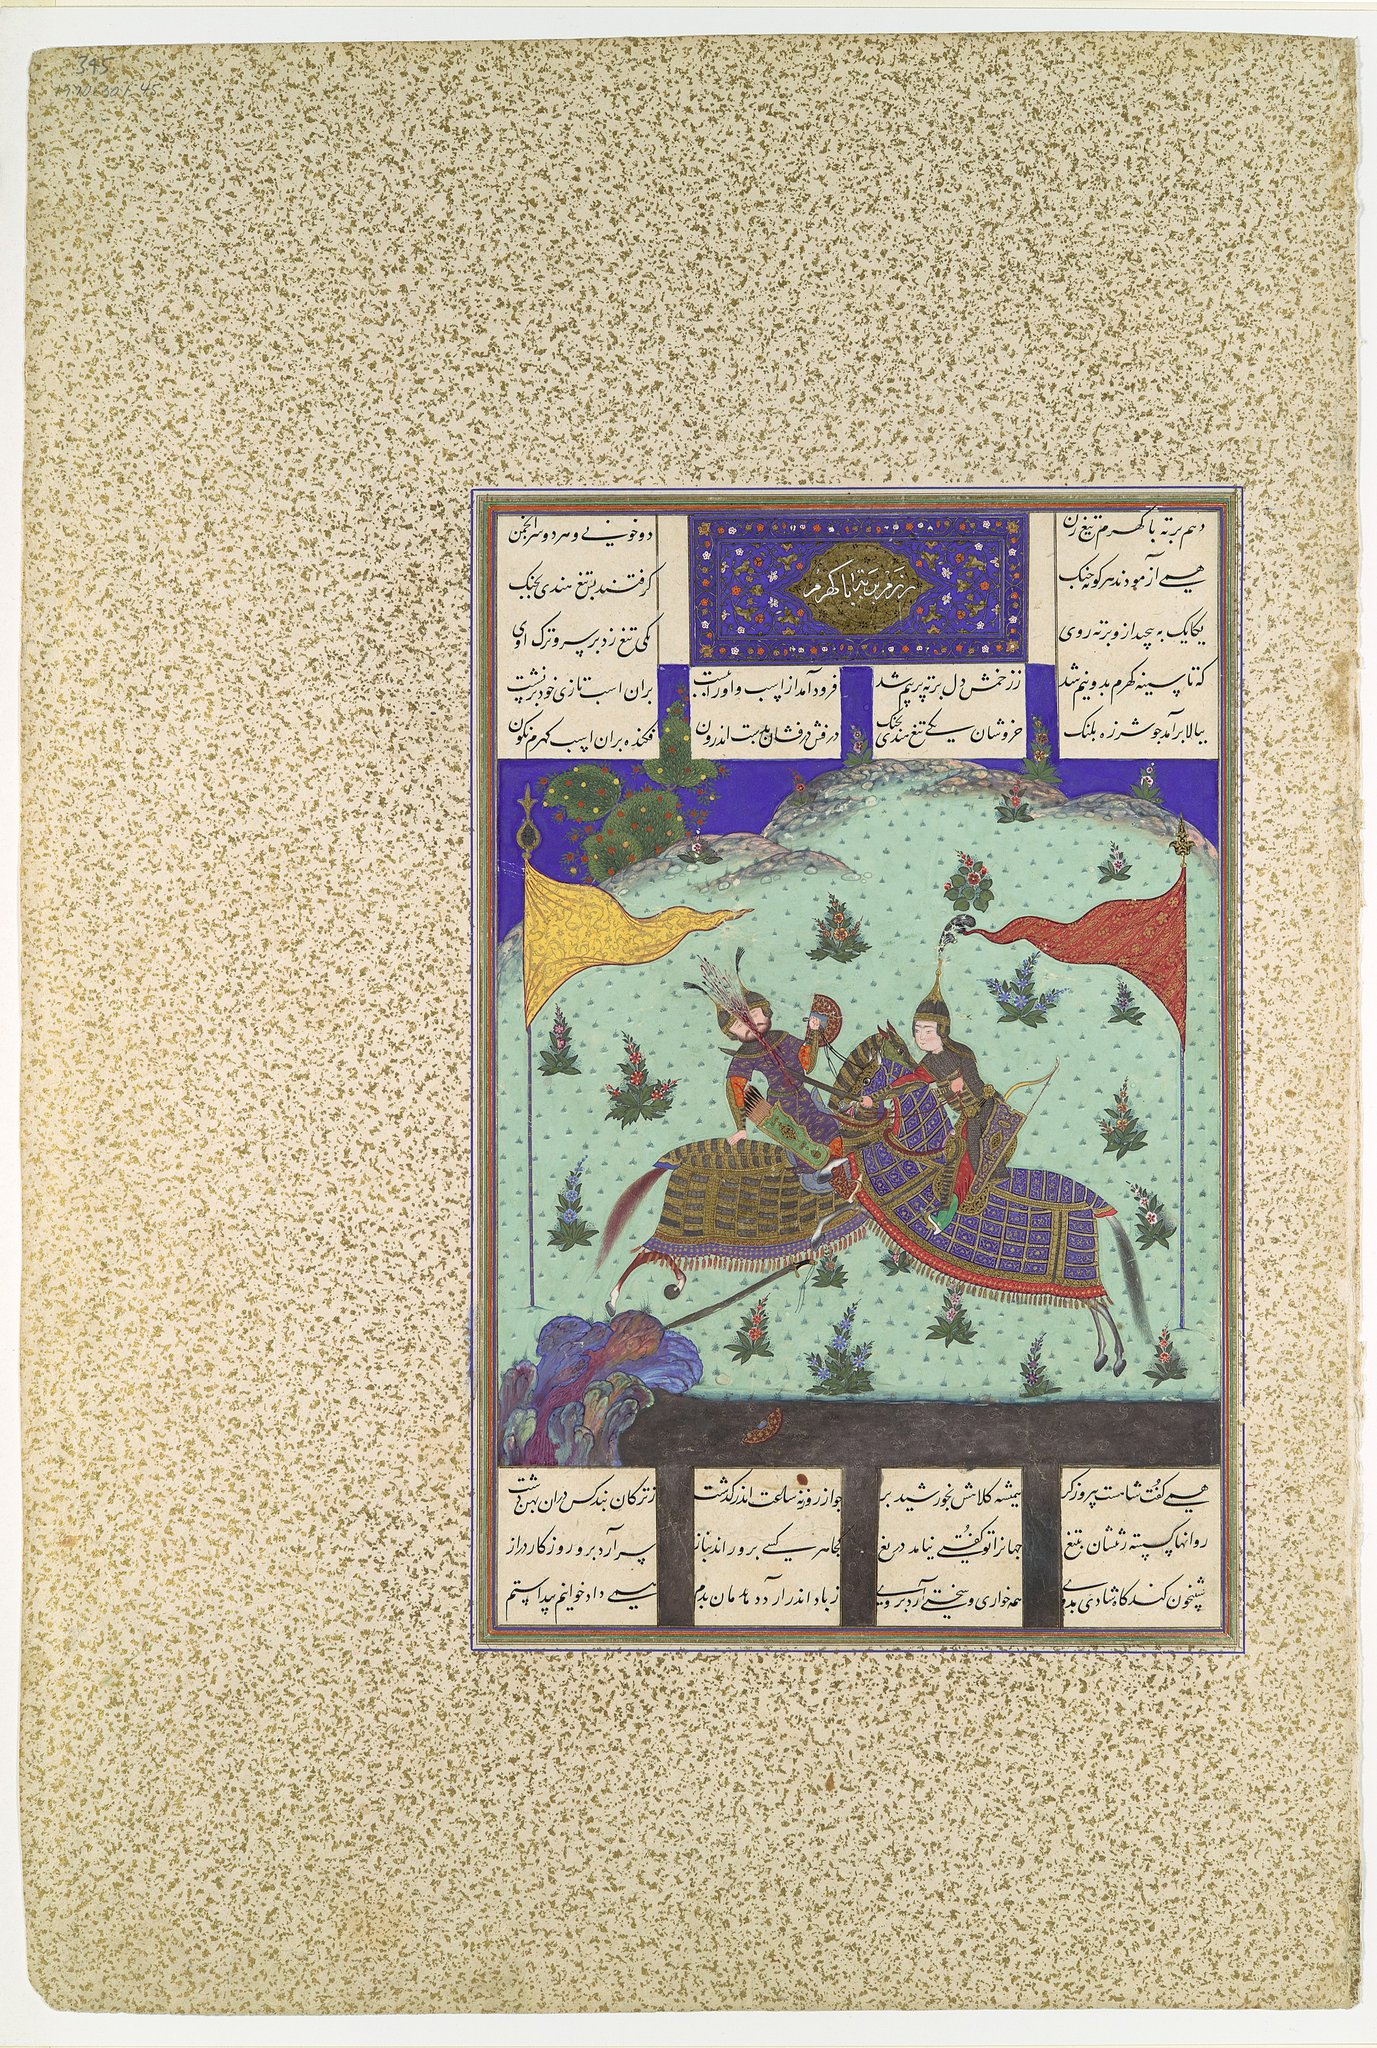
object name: folio from an illustrated manuscript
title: "The Tenth Joust of the Rooks: Barta versus Kuhram," Folio 345r from the Shahnama (Book of Kings) of Shah Tahmasp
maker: abu'l qasim firdausi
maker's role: author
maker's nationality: iranian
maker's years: 935-1020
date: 1525-1530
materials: gold, ink, paper, silver, watercolor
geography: iran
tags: battles,men,horses,flags